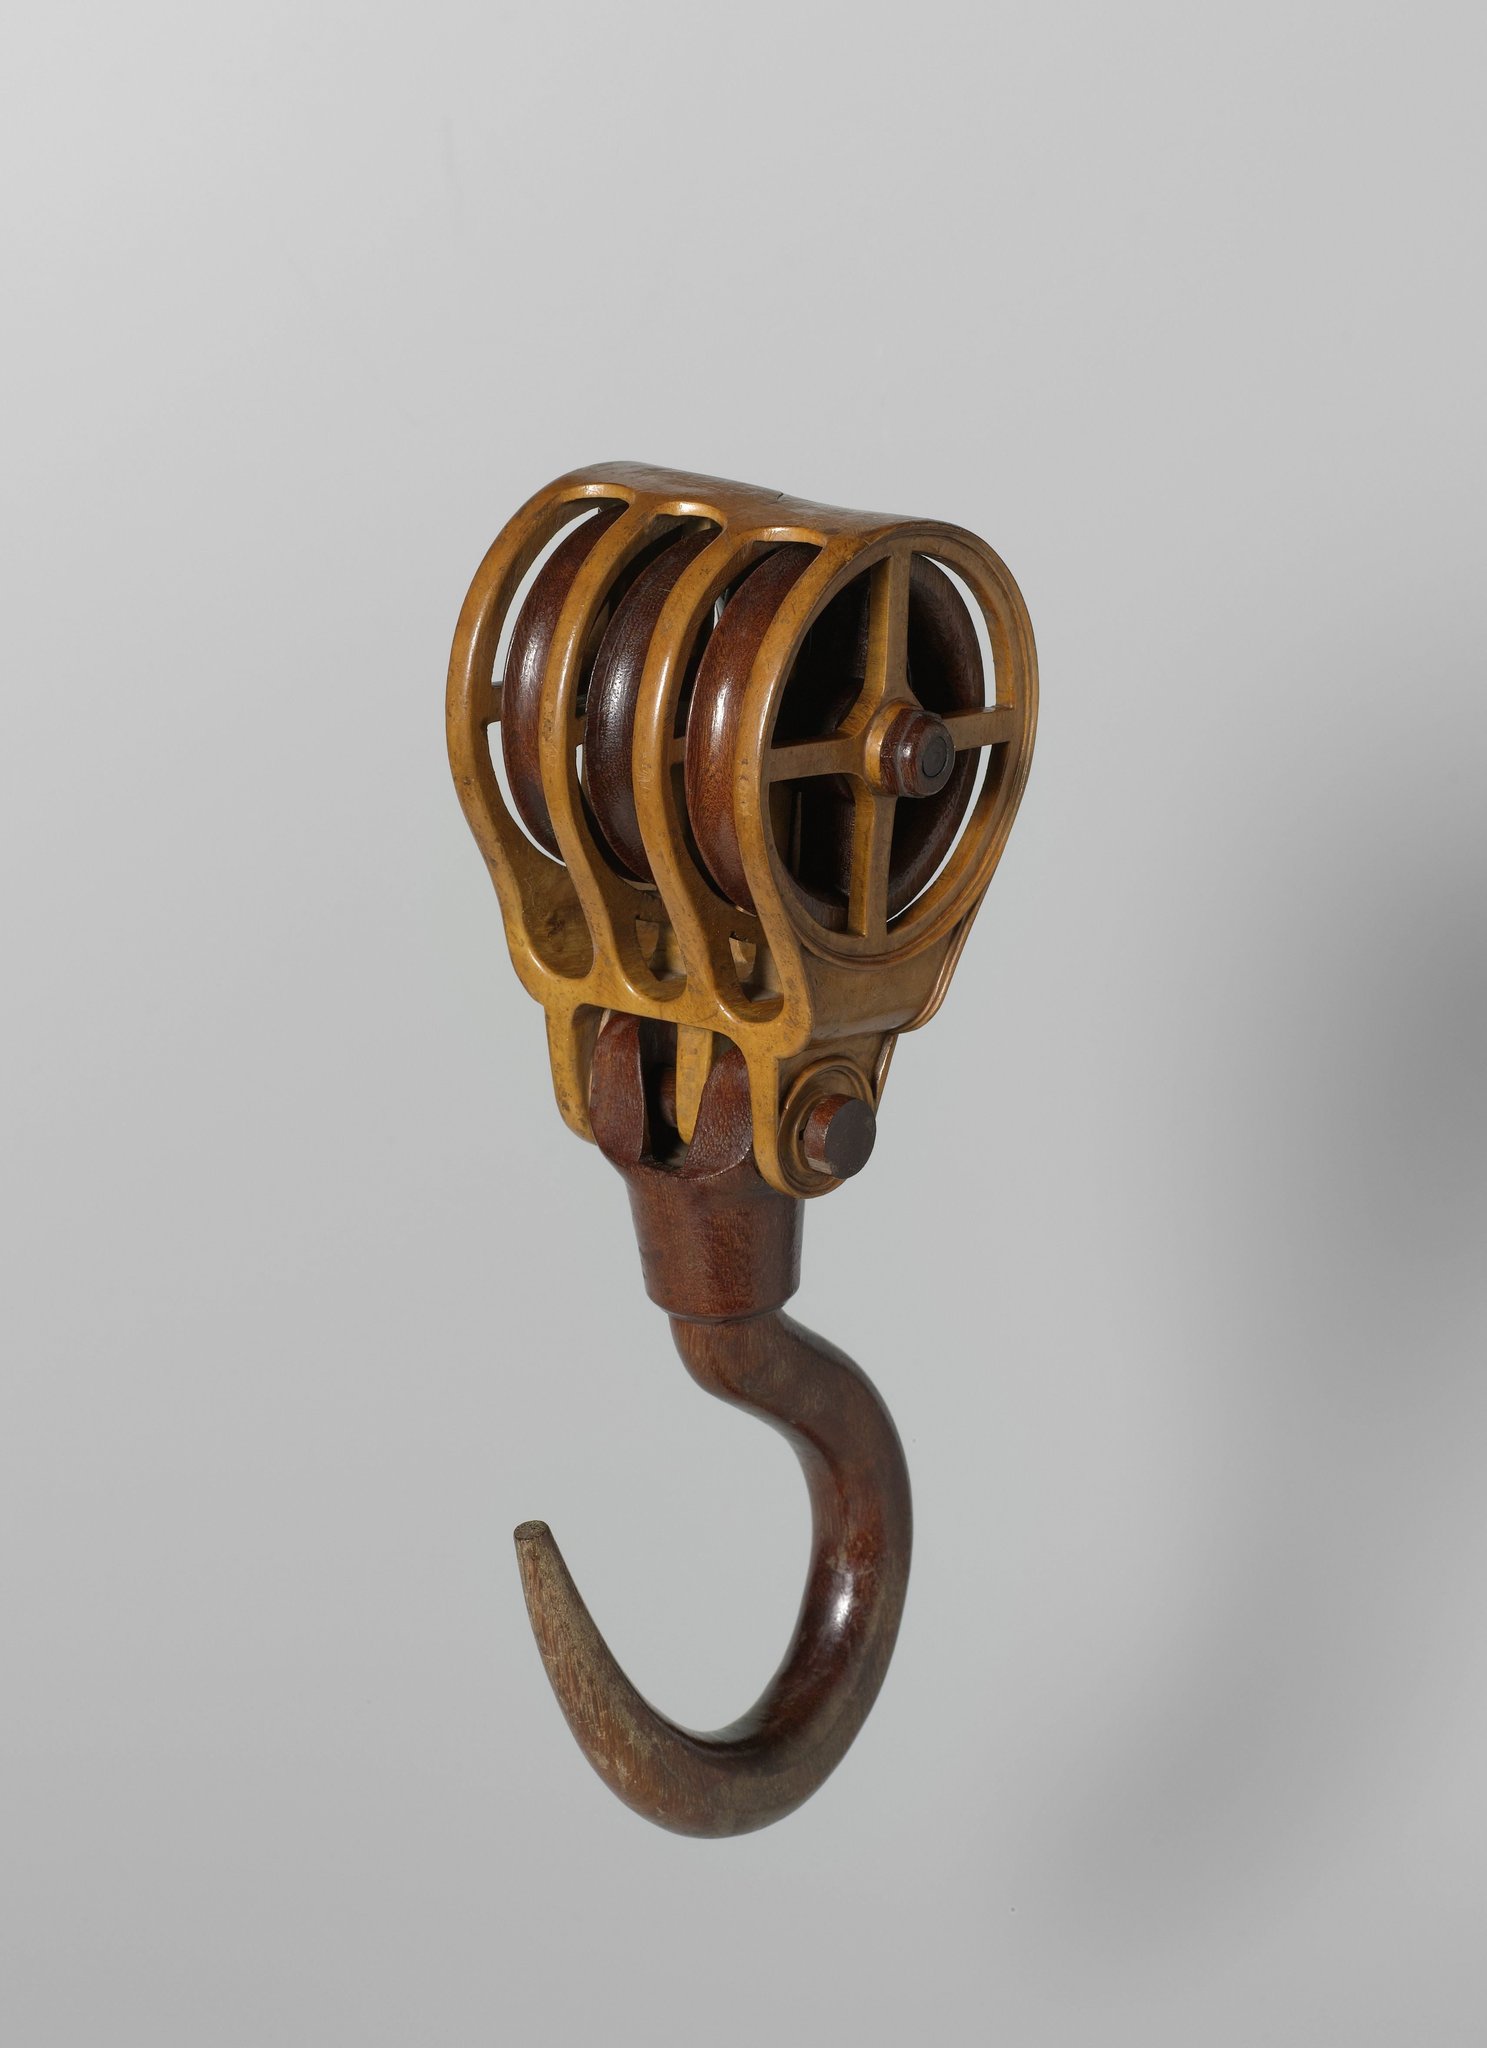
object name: demonstration model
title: Model of a Cat Block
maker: Anonymous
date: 1859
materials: wood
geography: russia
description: Model van een drieschijfsblok met opengewerkt huis; de schijven zijn wielen met vier spaken. Bovenop is een grote haak gemonteerd, die in twee richtingen kan draaien.